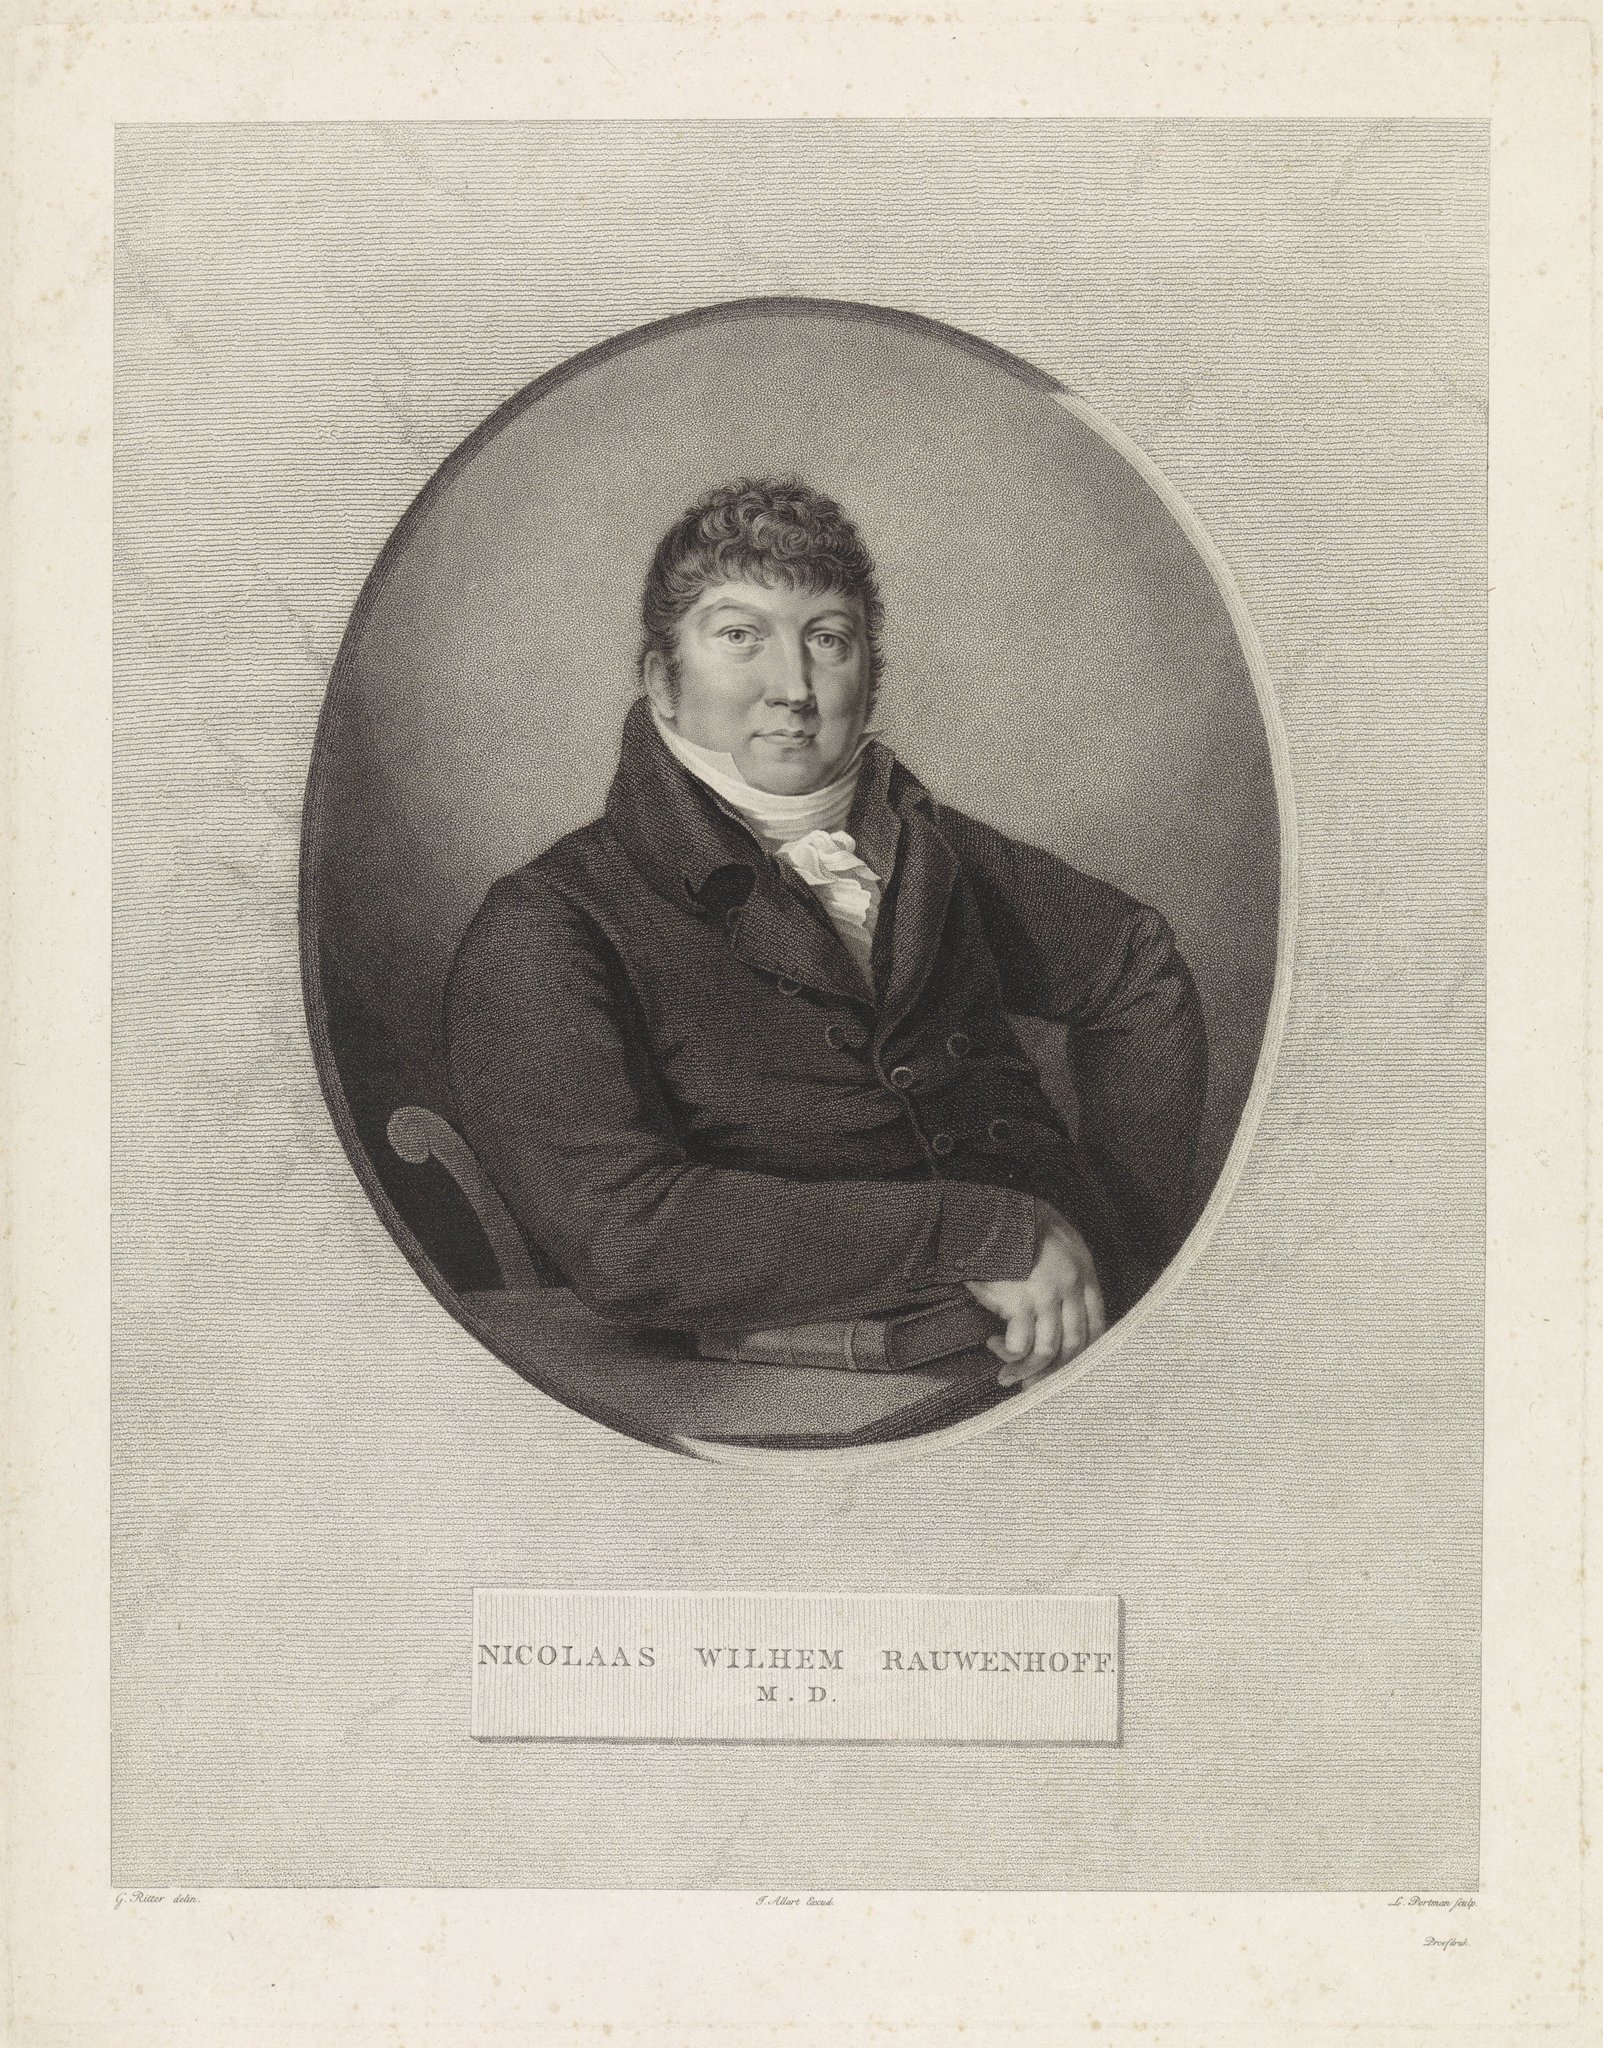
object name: print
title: Portret van de medicus Nicolaas Willem Rauwenhoff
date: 1794-1828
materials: paper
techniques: engraving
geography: amsterdam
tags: book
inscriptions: collector's mark: Lugt 2228